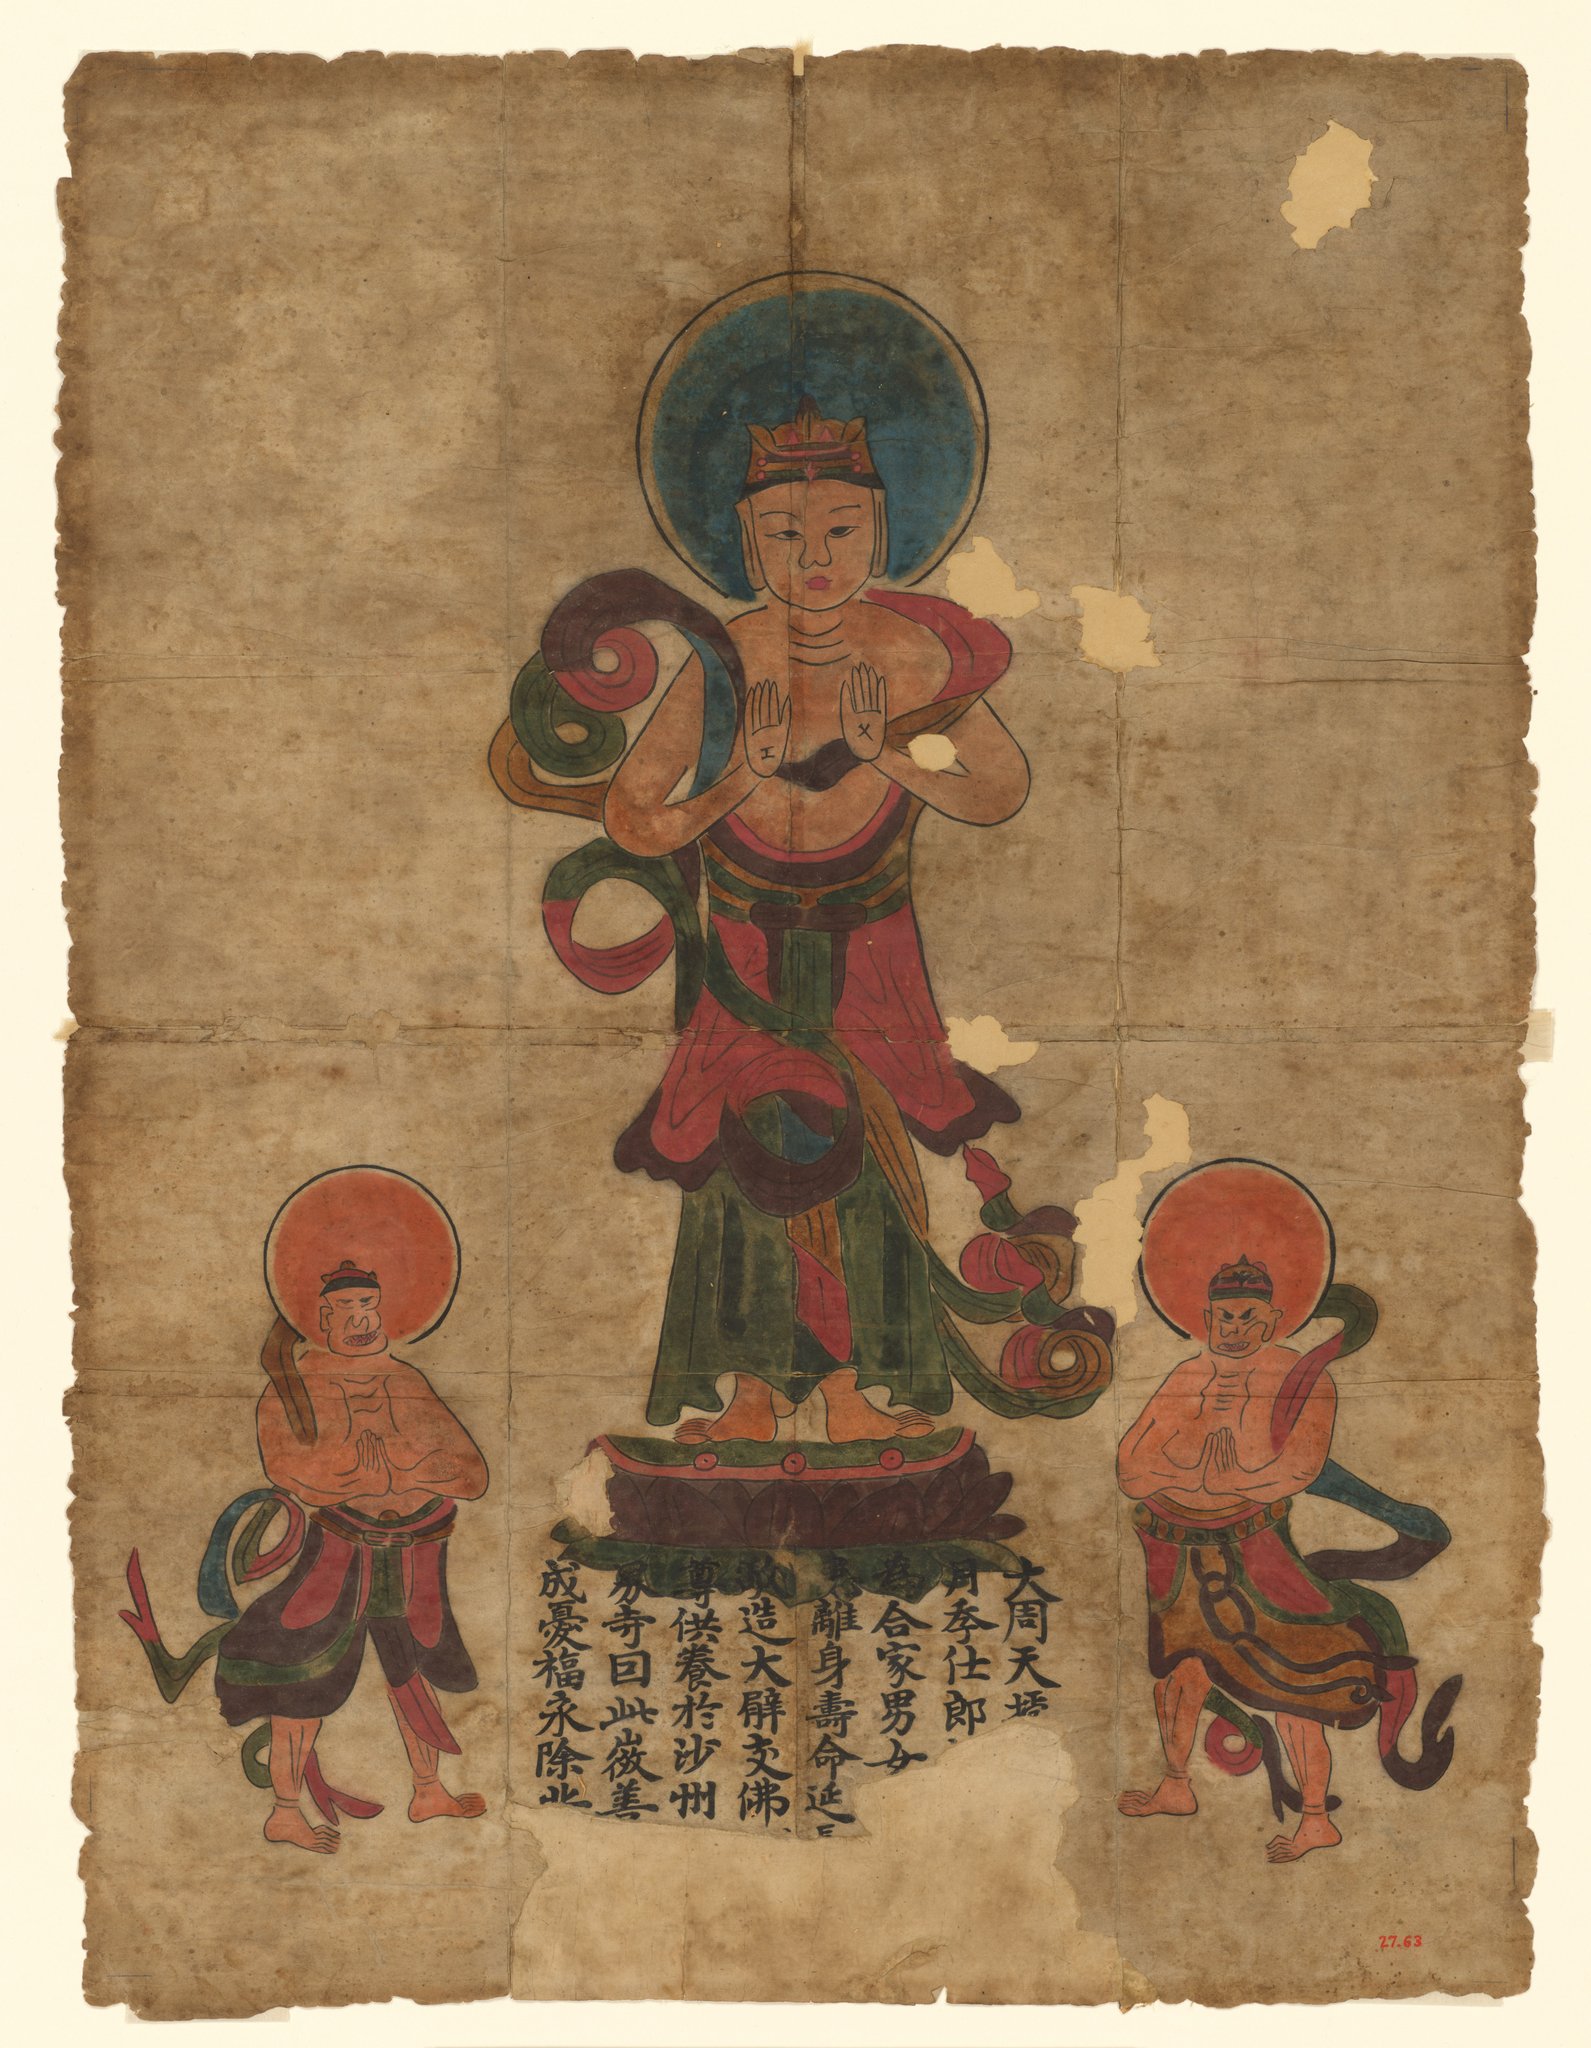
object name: matted painting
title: The Thousand Buddha Grotto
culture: chinese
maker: unidentified artist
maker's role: artist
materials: ink, paper